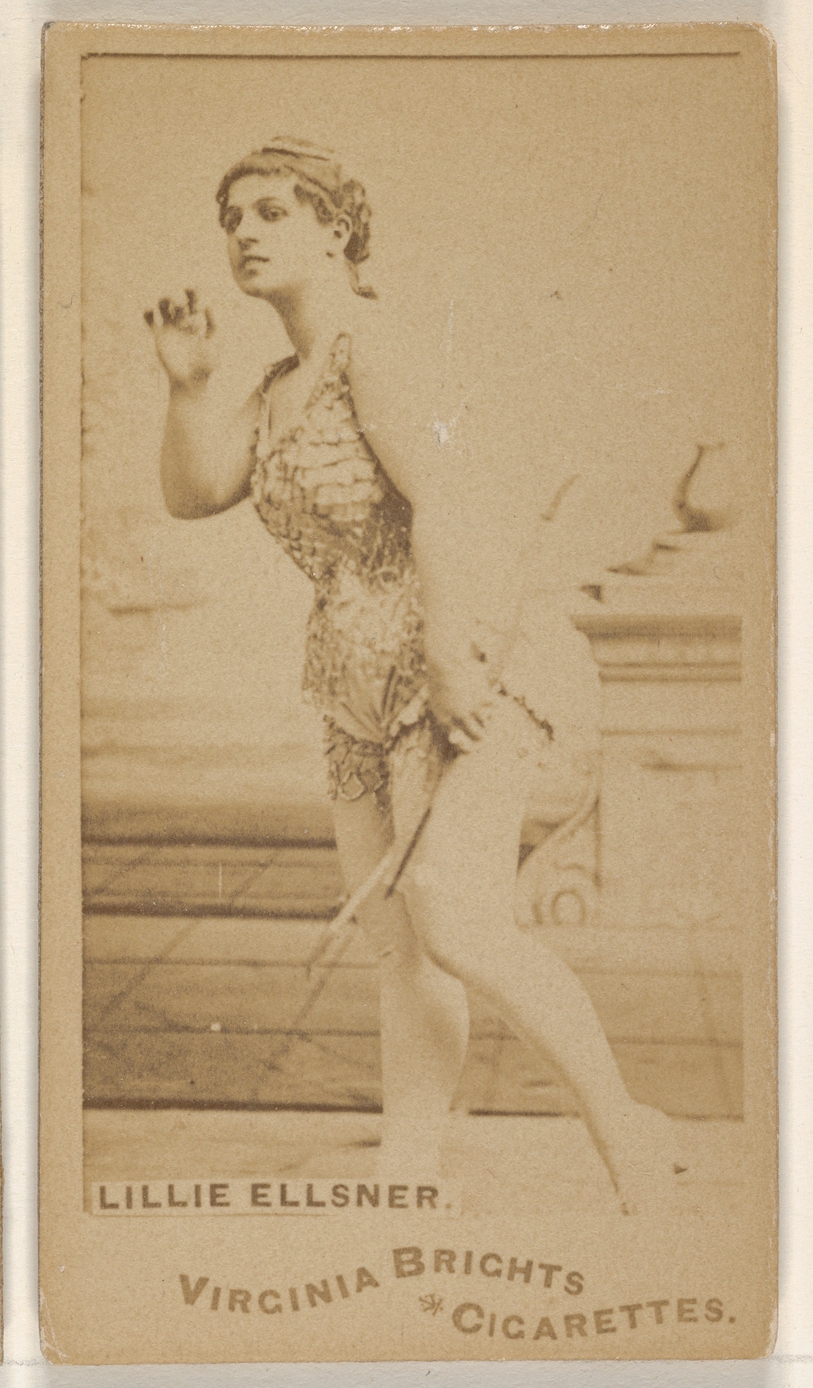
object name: photograph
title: Lillie Ellsner, from the Actors and Actresses series (N45, Type 1) for Virginia Brights Cigarettes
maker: allen & ginter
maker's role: publisher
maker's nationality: american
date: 1888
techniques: albumen silver print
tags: portraits,women,actresses